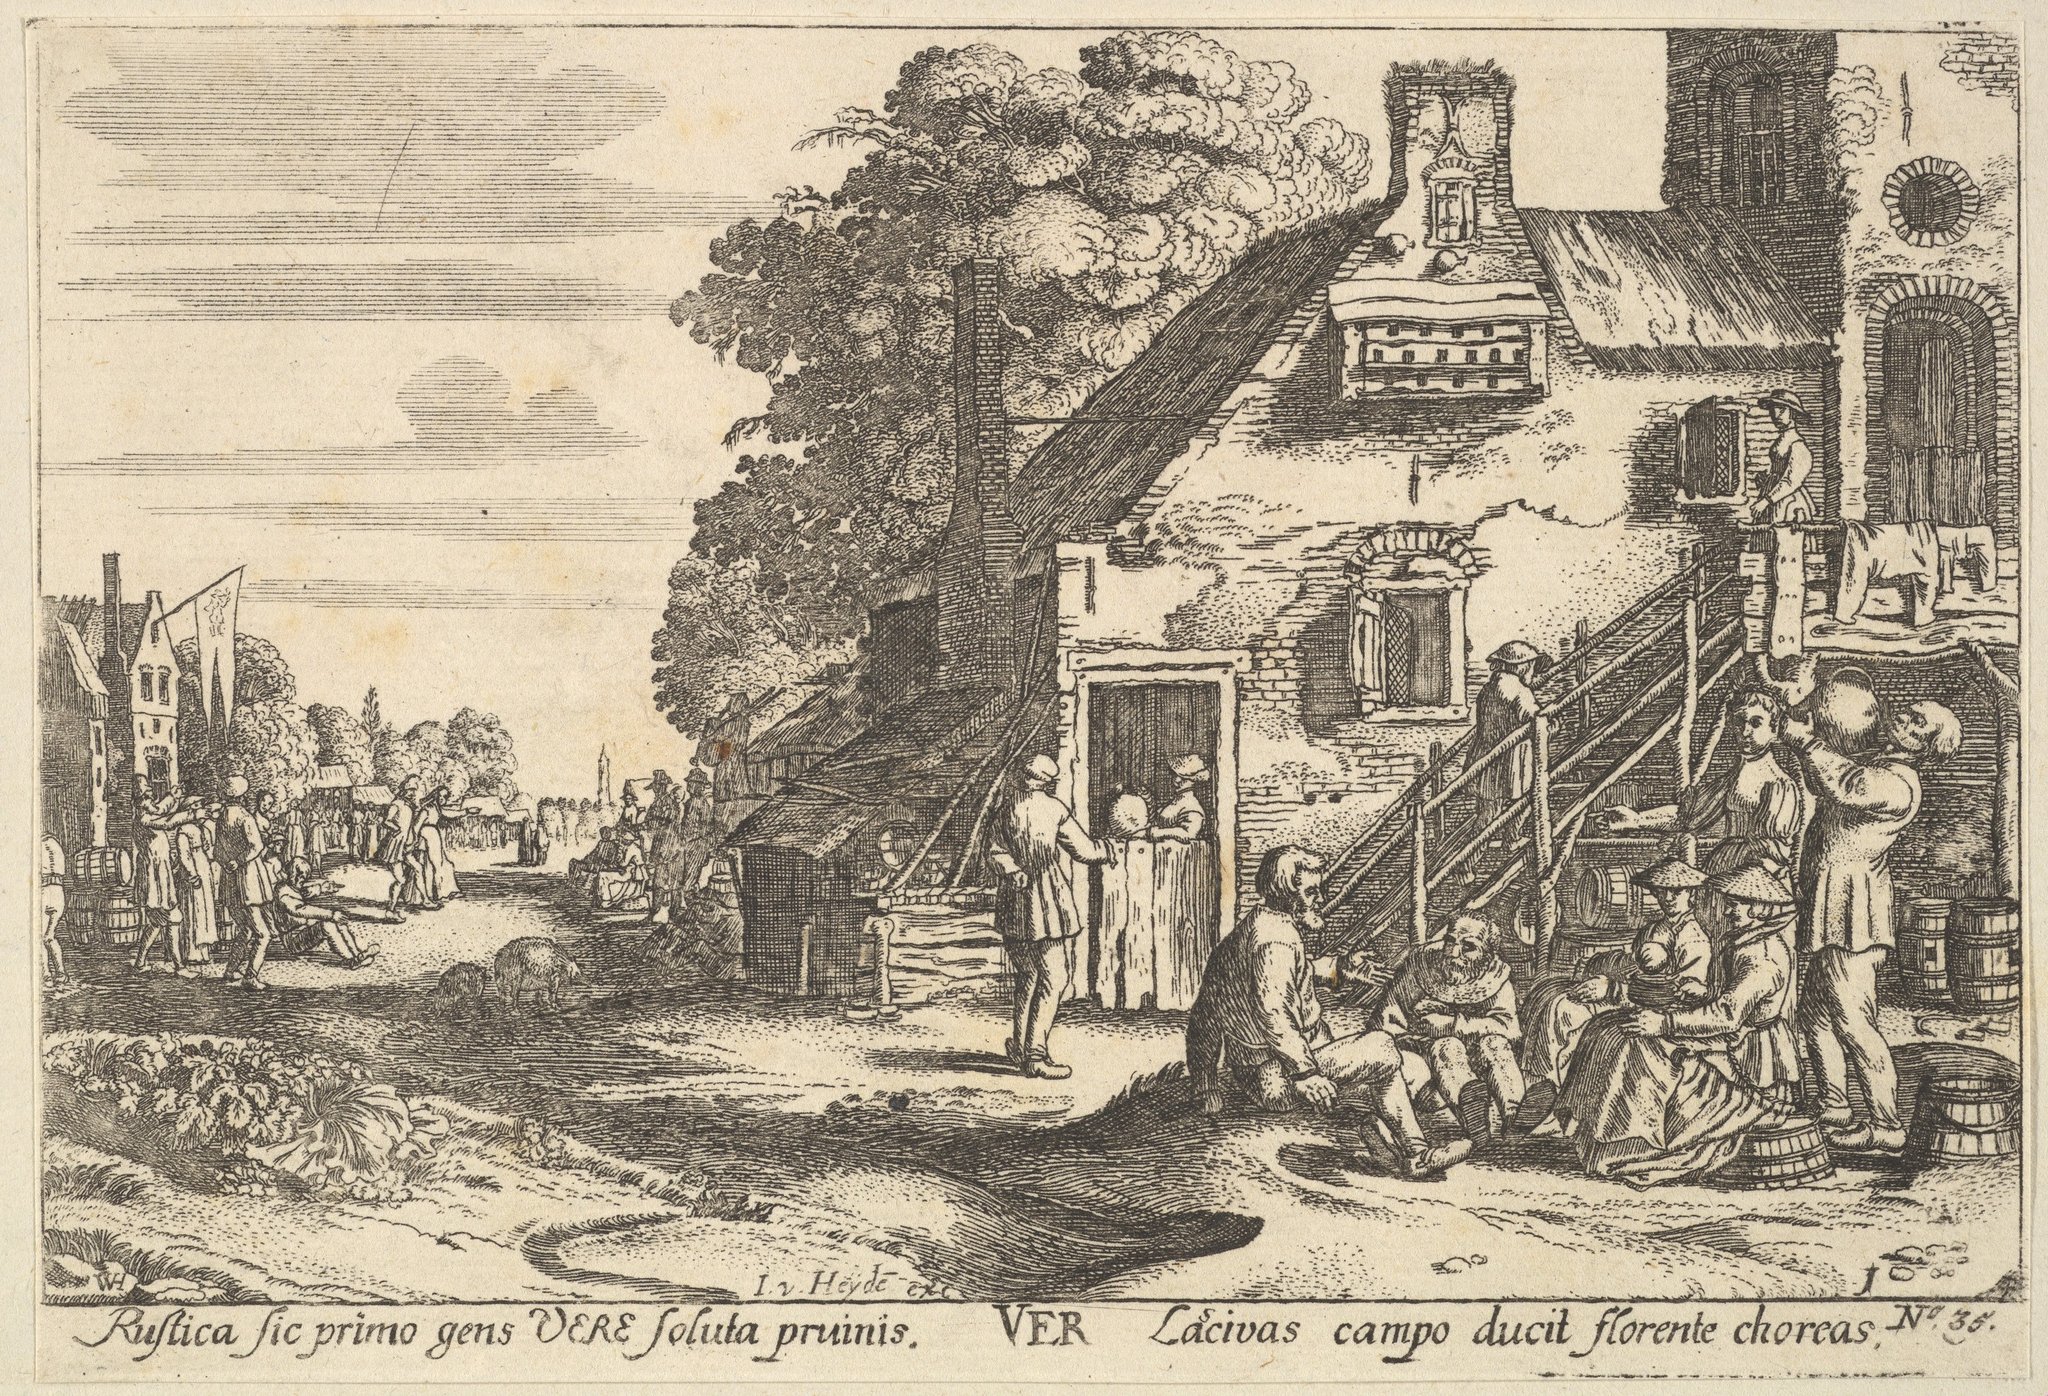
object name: print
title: Ver (Spring)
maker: wenceslaus hollar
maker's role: artist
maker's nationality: bohemian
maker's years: 1607-1677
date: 1629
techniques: etching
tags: houses,men,women,spring